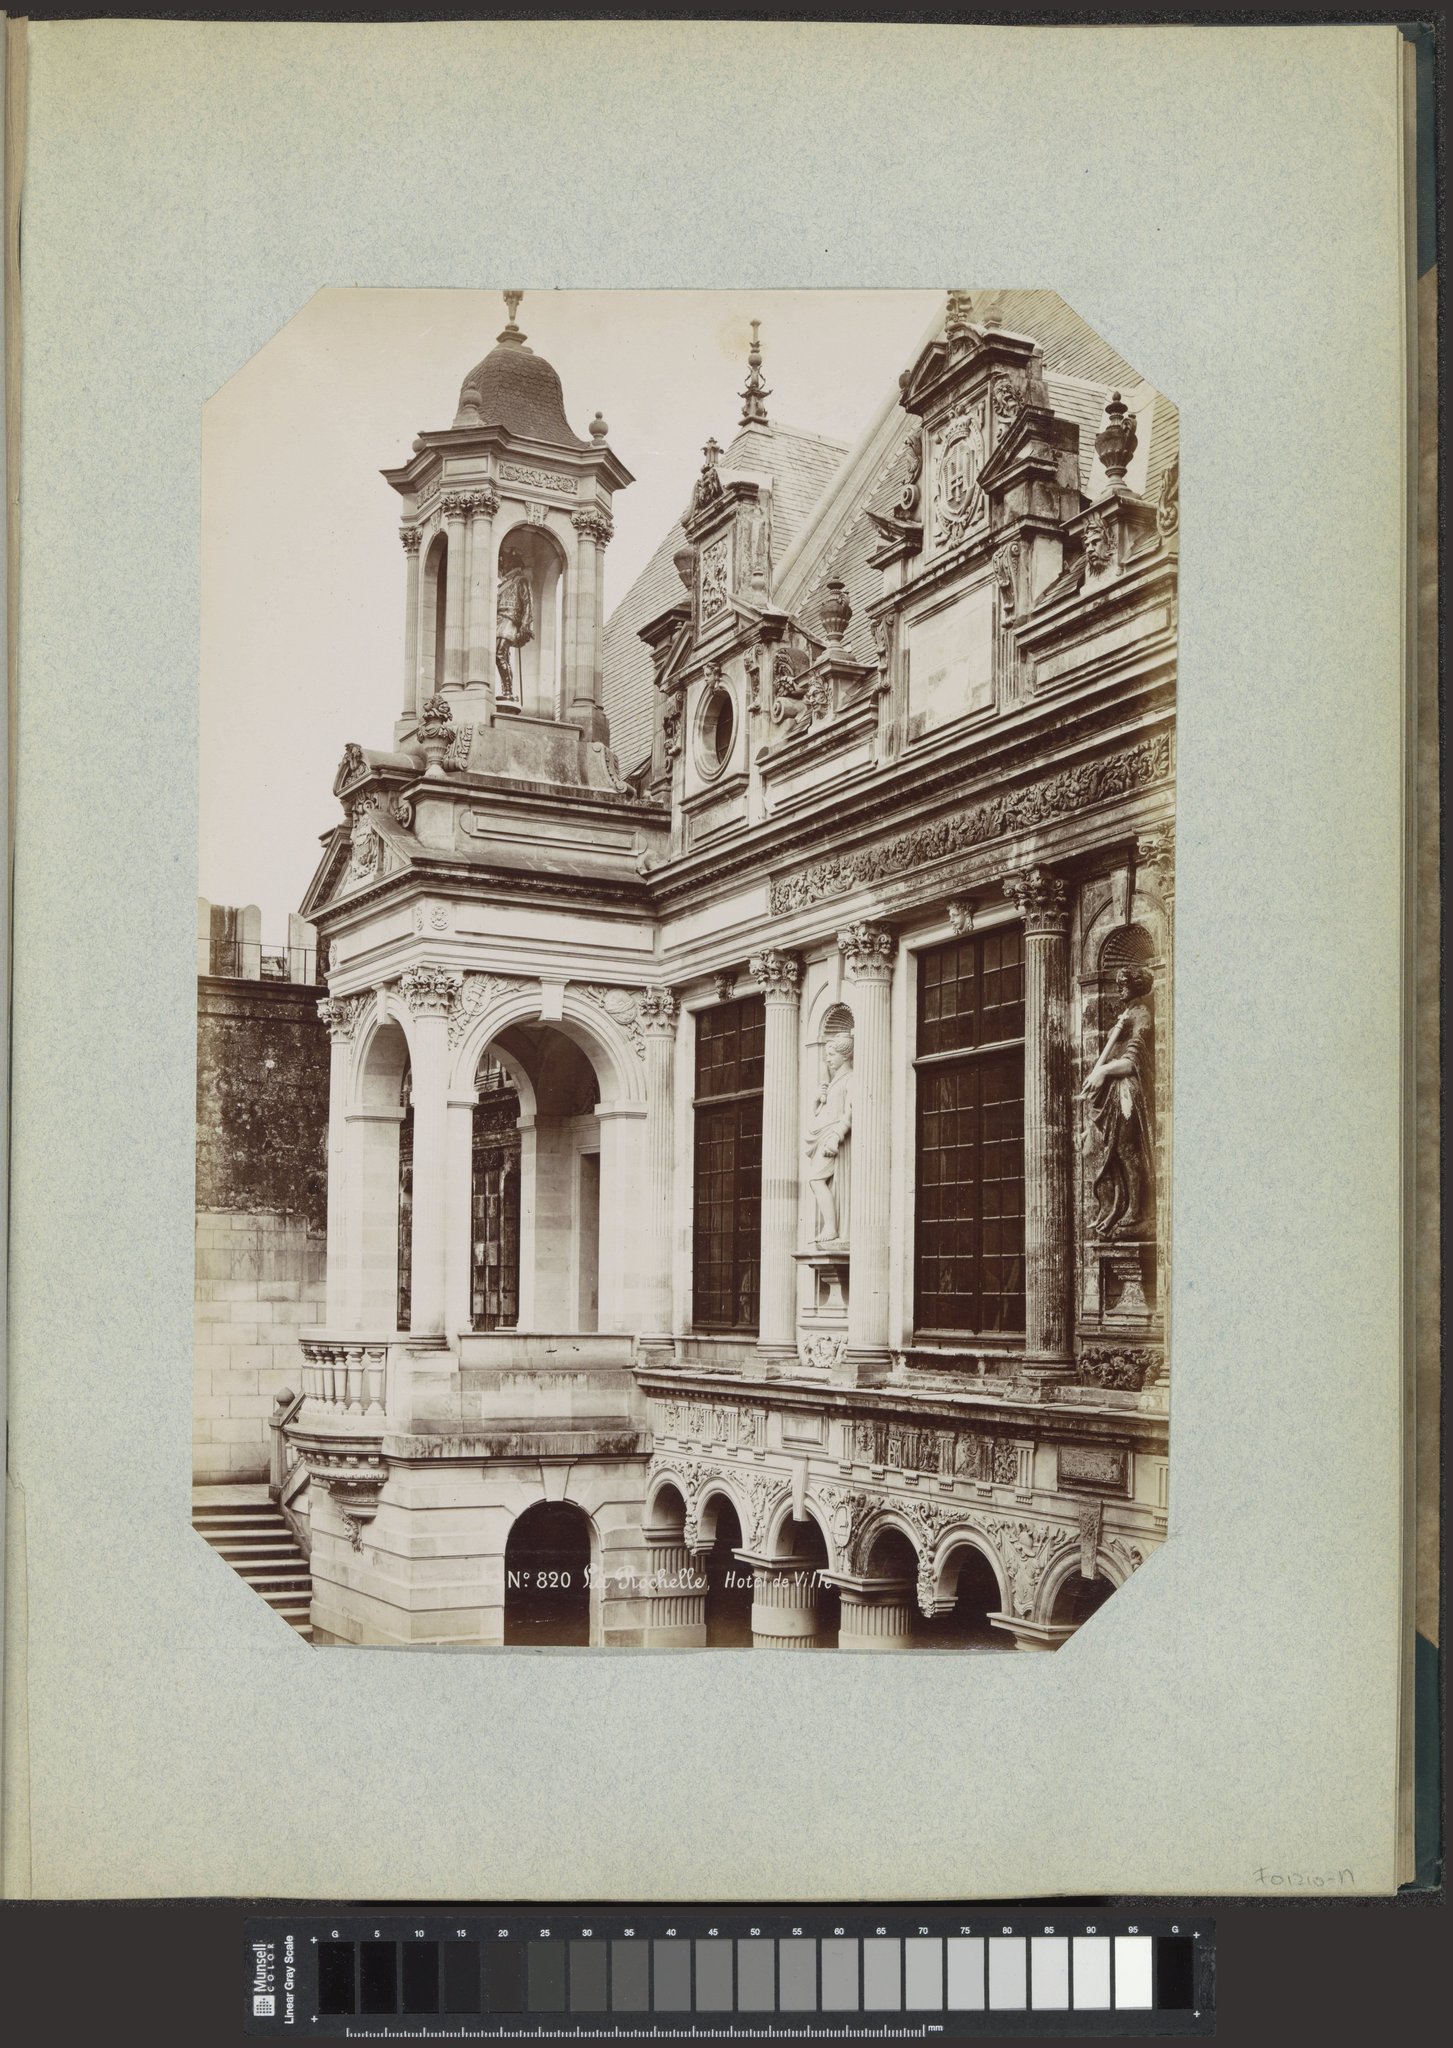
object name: photograph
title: Deel van het exterieur van het stadhuis van La Rochelle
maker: séraphin-médéric mieusement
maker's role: fotograaf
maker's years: 1840-1905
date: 1880-1900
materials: photographic support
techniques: albumen print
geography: la rochelle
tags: townhall, façade (of house or building)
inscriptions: number: ‘820’, inscription: ‘Monuments Historiques’, name: ‘Mieusement photographe’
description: Onderdeel van Fotoalbum met opnames van monumenten in Frankrijk.